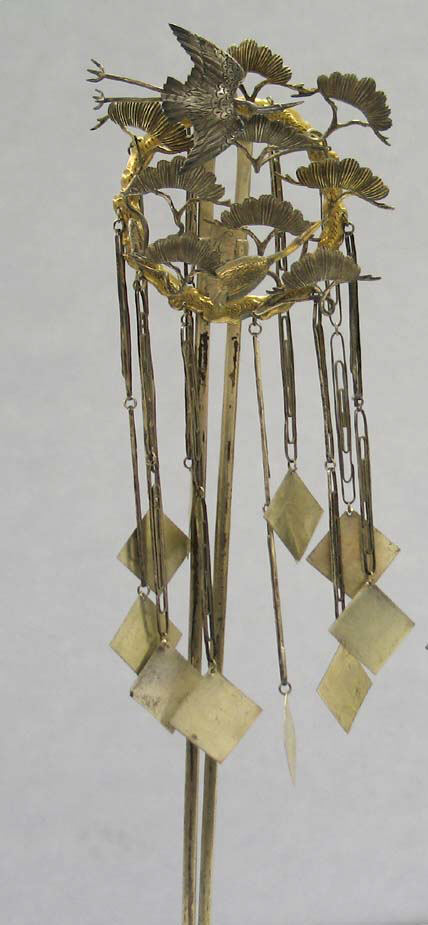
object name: hair ornament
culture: japanese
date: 1867-1900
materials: silver, silver gilt